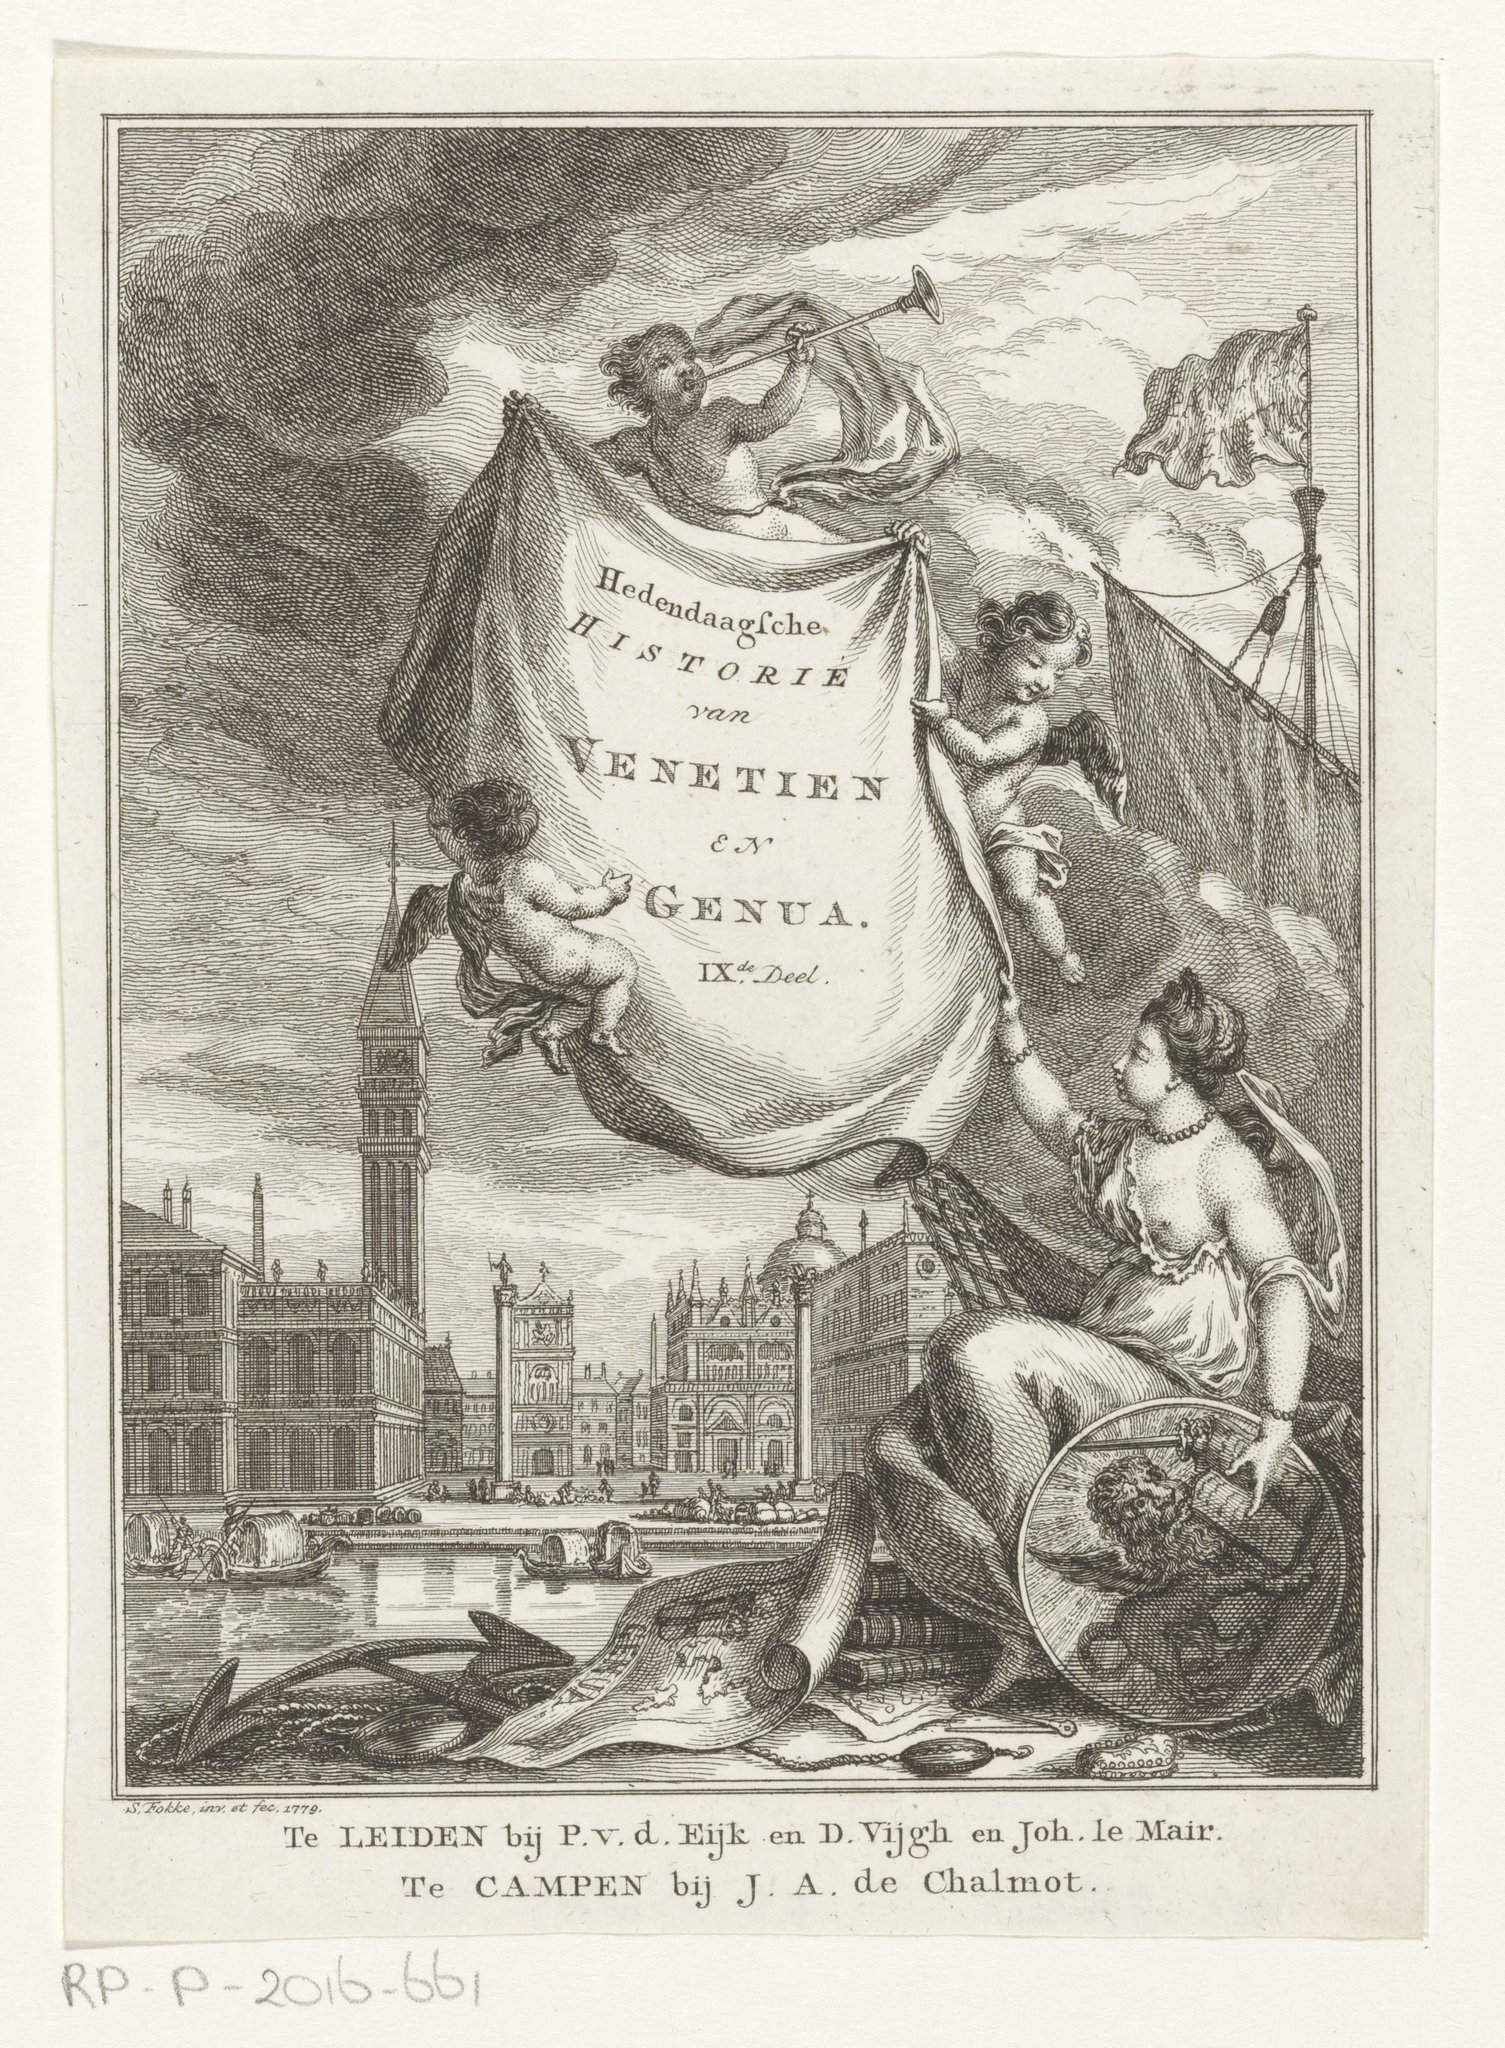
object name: titelblad, titelpagina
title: Titelpagina voor: S.n., Hedendaagsche historie of Het vervolg van de Algemeene historie, 1779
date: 1779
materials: paper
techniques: engraving, etching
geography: leiden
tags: cities represented allegorically or symbolically, venice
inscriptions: collector's mark: Lugt 2228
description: Drie putti houden een doek met de titel in de lucht. Rechts zit een vrouw met een schild met een leeuw. Bij haar voeten liggen een kaart van Genua, een anker en boeken. In de achtergrond een gezicht op Venetië.